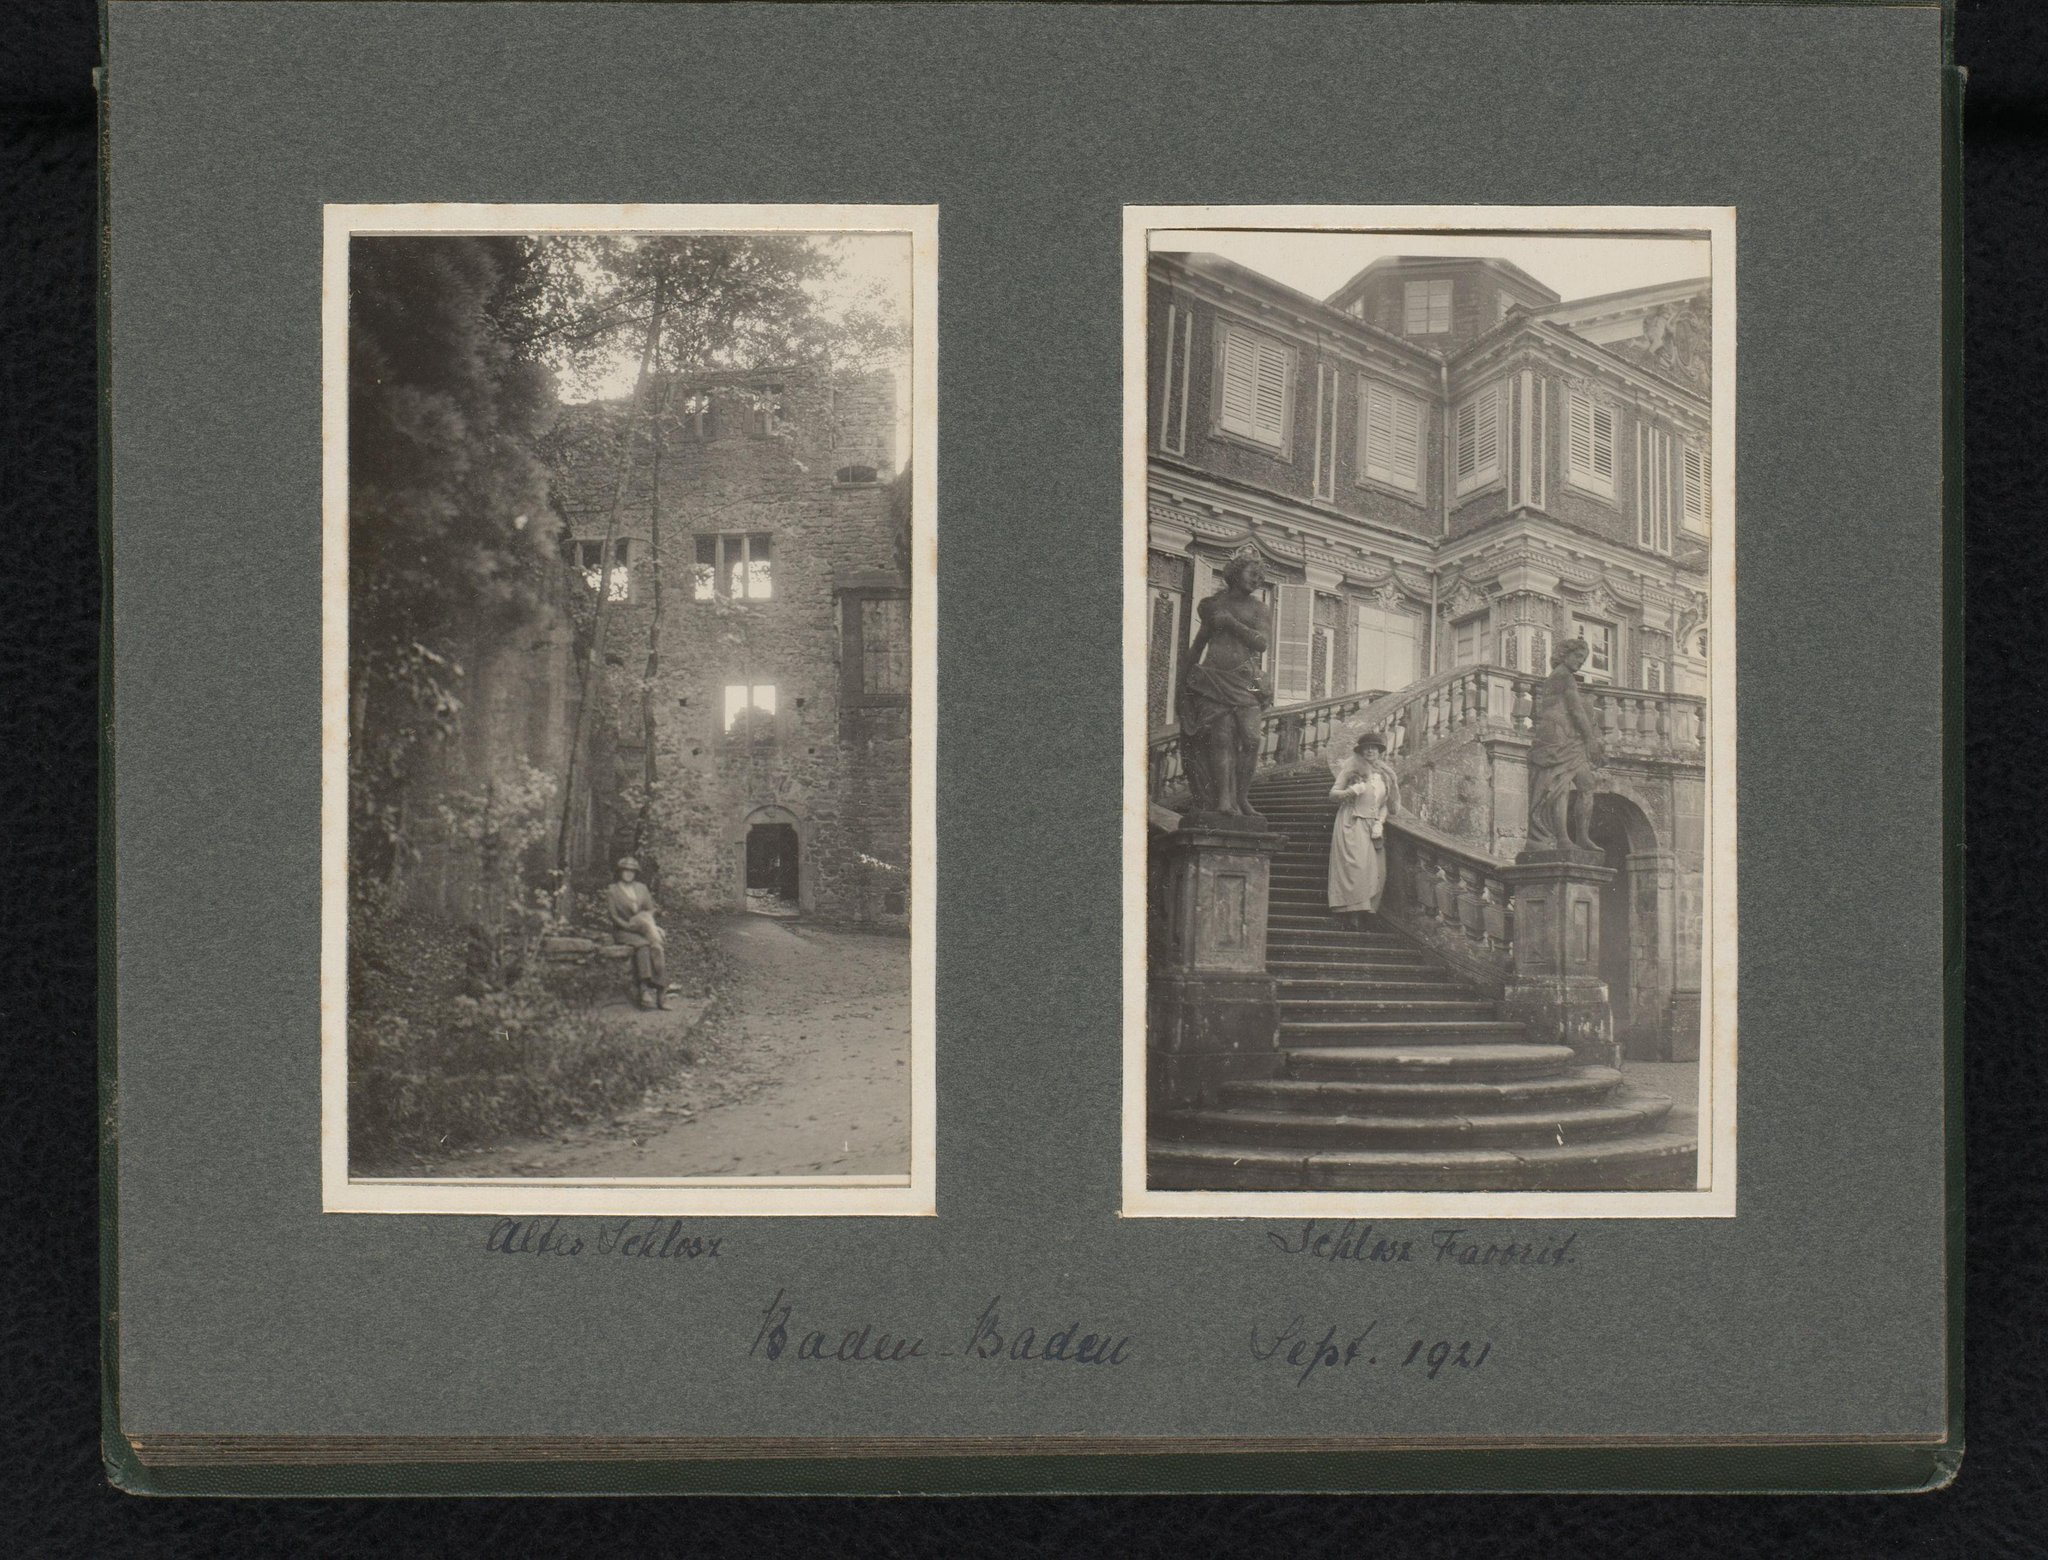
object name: album leaf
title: Twee foto's van Caroline van den Berg bij slot Hohenbaden en slot Favorite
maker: hendrik herman van den berg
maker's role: amateurfotograaf, jurist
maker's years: 1875-1944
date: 1909-1921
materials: paper, cardboard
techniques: gelatin silver print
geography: baden-baden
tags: the hague, caroline louise van den berg-van den berg, castle, historical persons, ruin of a dwelling, house, castle, etc.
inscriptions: caption: ‘Baden-Baden Sept 1921/ [...]see /Baden-Baden Sept 1921/ Merkurwald’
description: Deze foto's maken deel uit van een album.